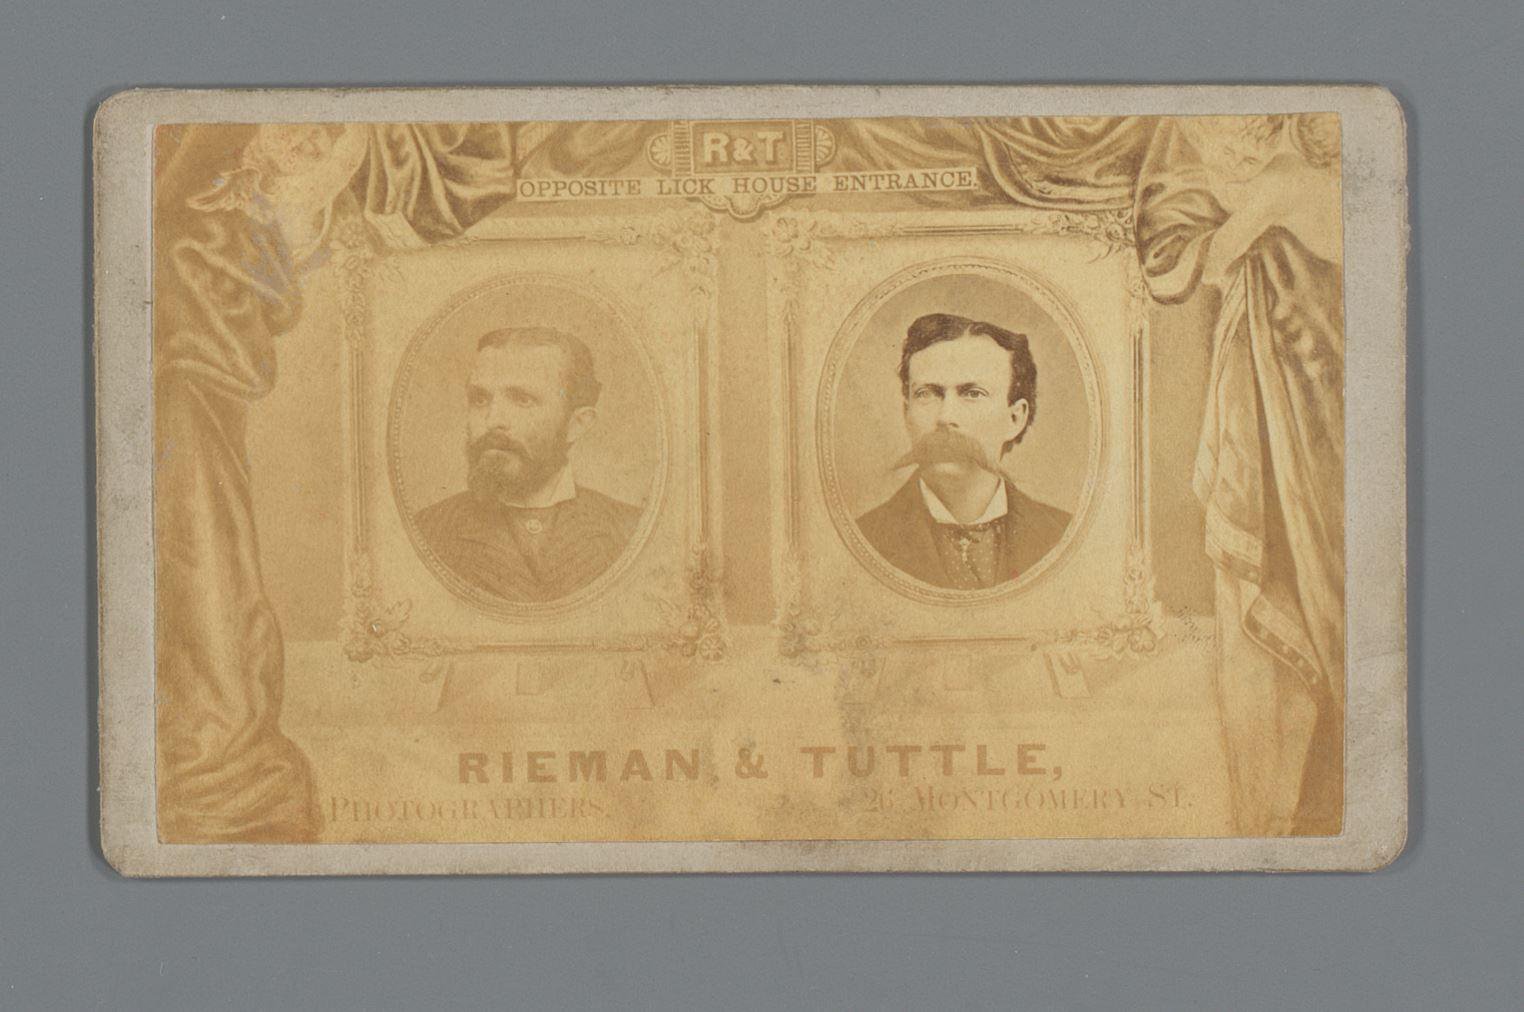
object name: carte de visite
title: Fotoreproductie van een visitekaartje met portretten van de fotografen Rieman and Tuttle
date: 1879-1895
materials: cardboard, paper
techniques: albumen print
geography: san francisco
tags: adult man, photographer at work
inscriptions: inscription: ‘Rieman and Tuttle/ PHOTOGRAPHERS,/ 26 Montgomery Street,/ Opposite Lick House Entrance,/ SAN FRANCISCO.’, stamp: ‘[..]/ San Francisco,’, inscription: ‘YUE 7/ 1500’